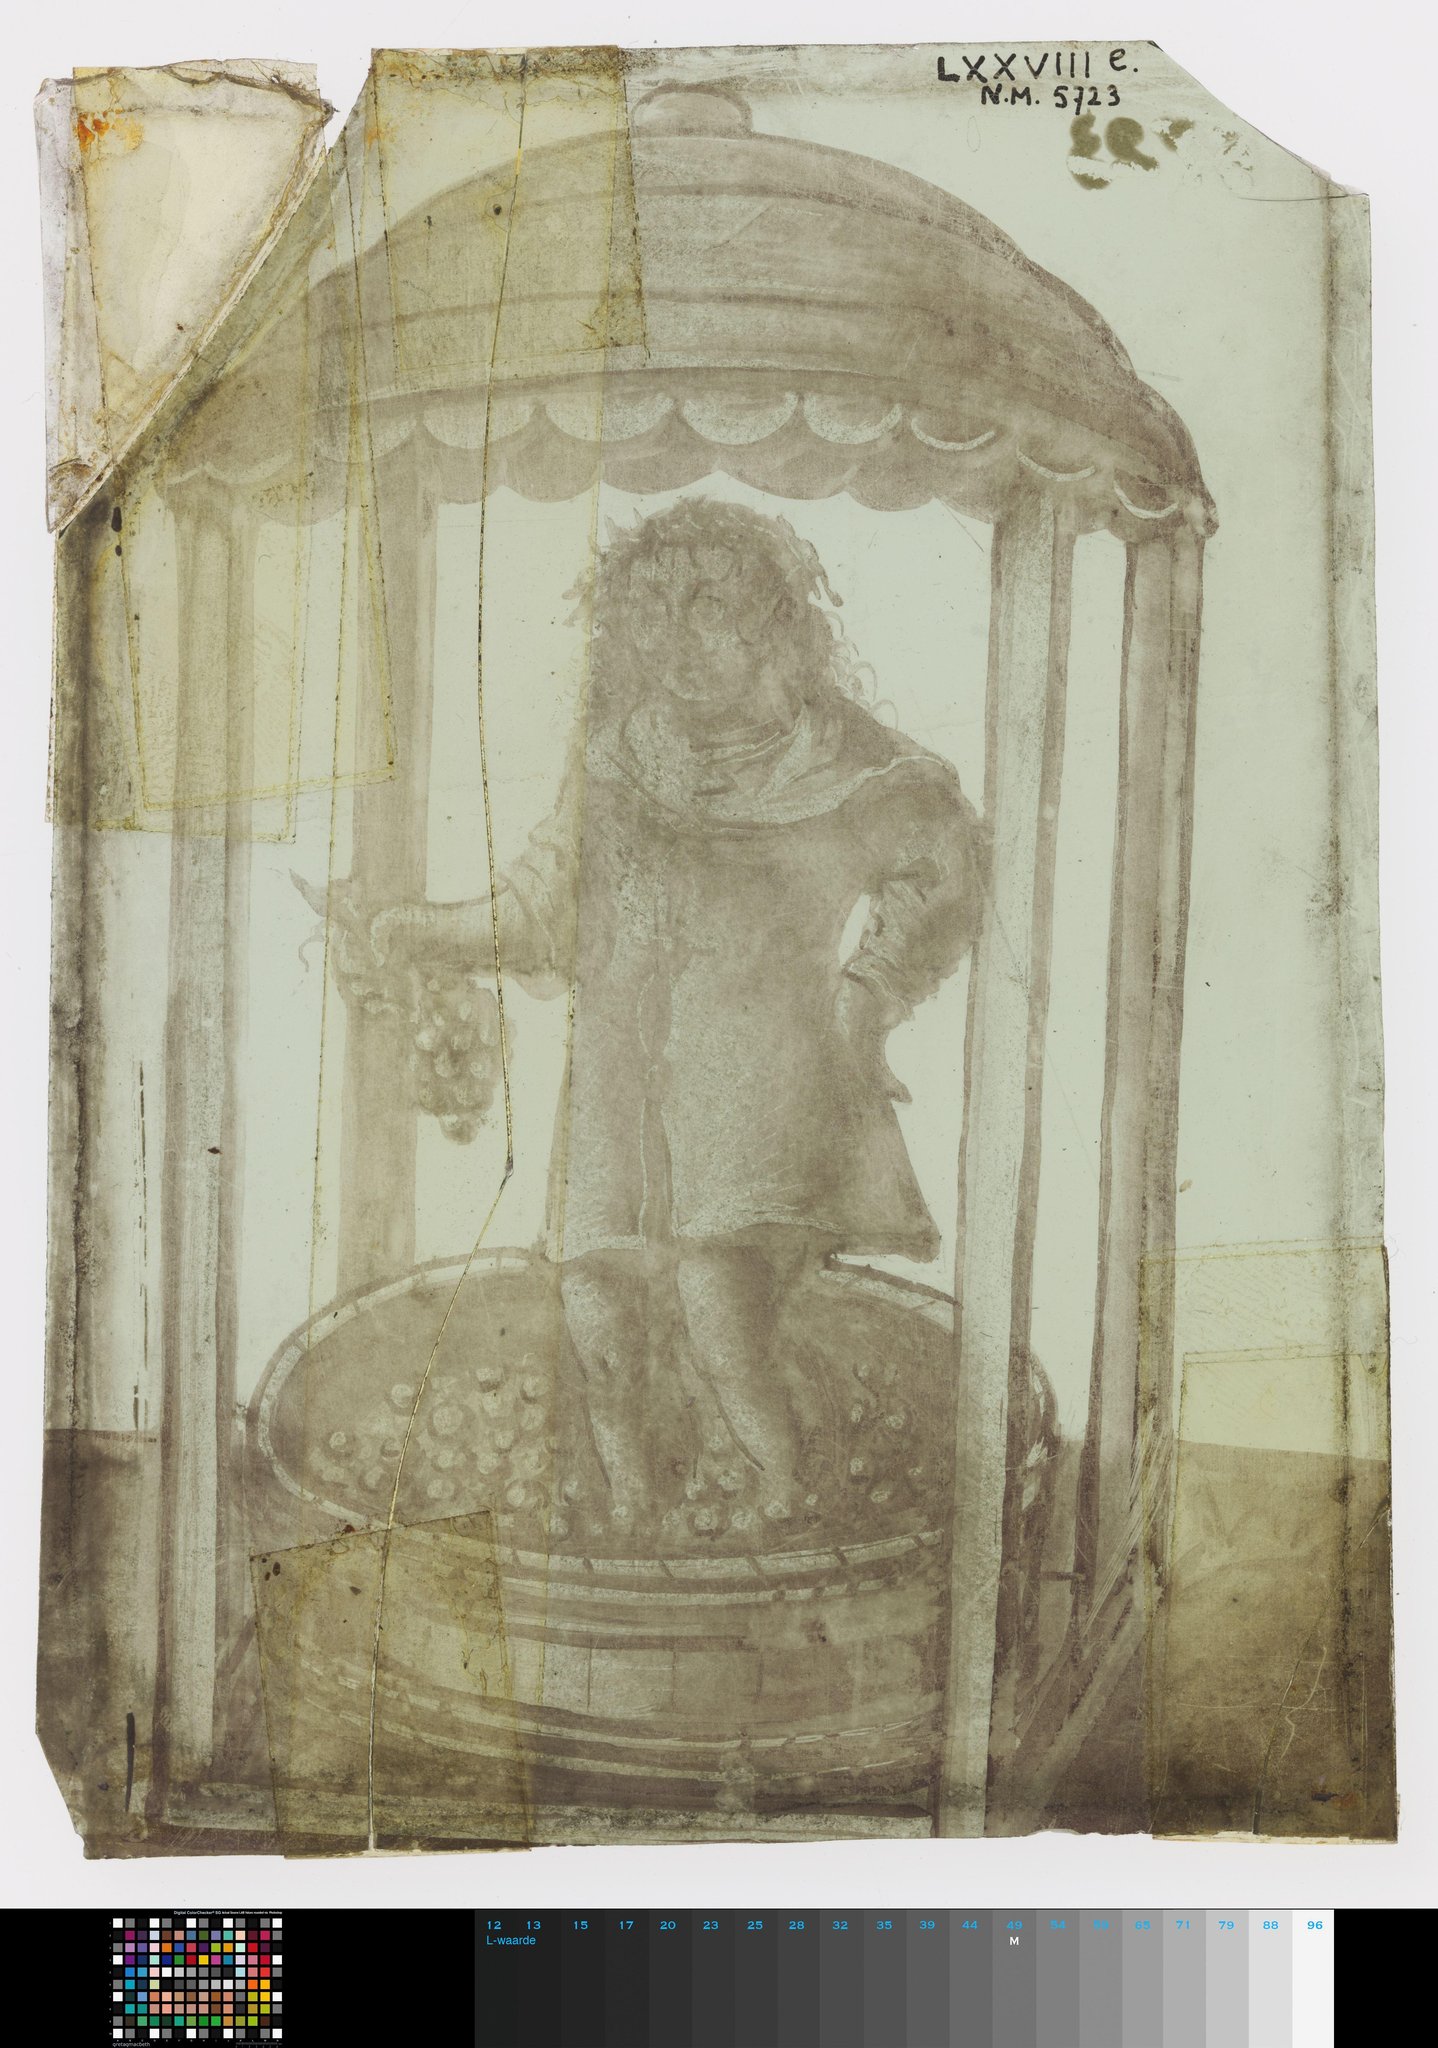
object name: light window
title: Ruit met boer stampend op druiven onder een rond baldakijn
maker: Anonymous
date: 1650-1675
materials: glass, lead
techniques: enamel painting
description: Een gebrandschilderd ruitje waarop afgebeeld een boer, druiven trappende, onder een rond baldakijn, in grisaille. Opmerking: Onderdeel van de groep LXXVIII a t/m i en k t/m m.